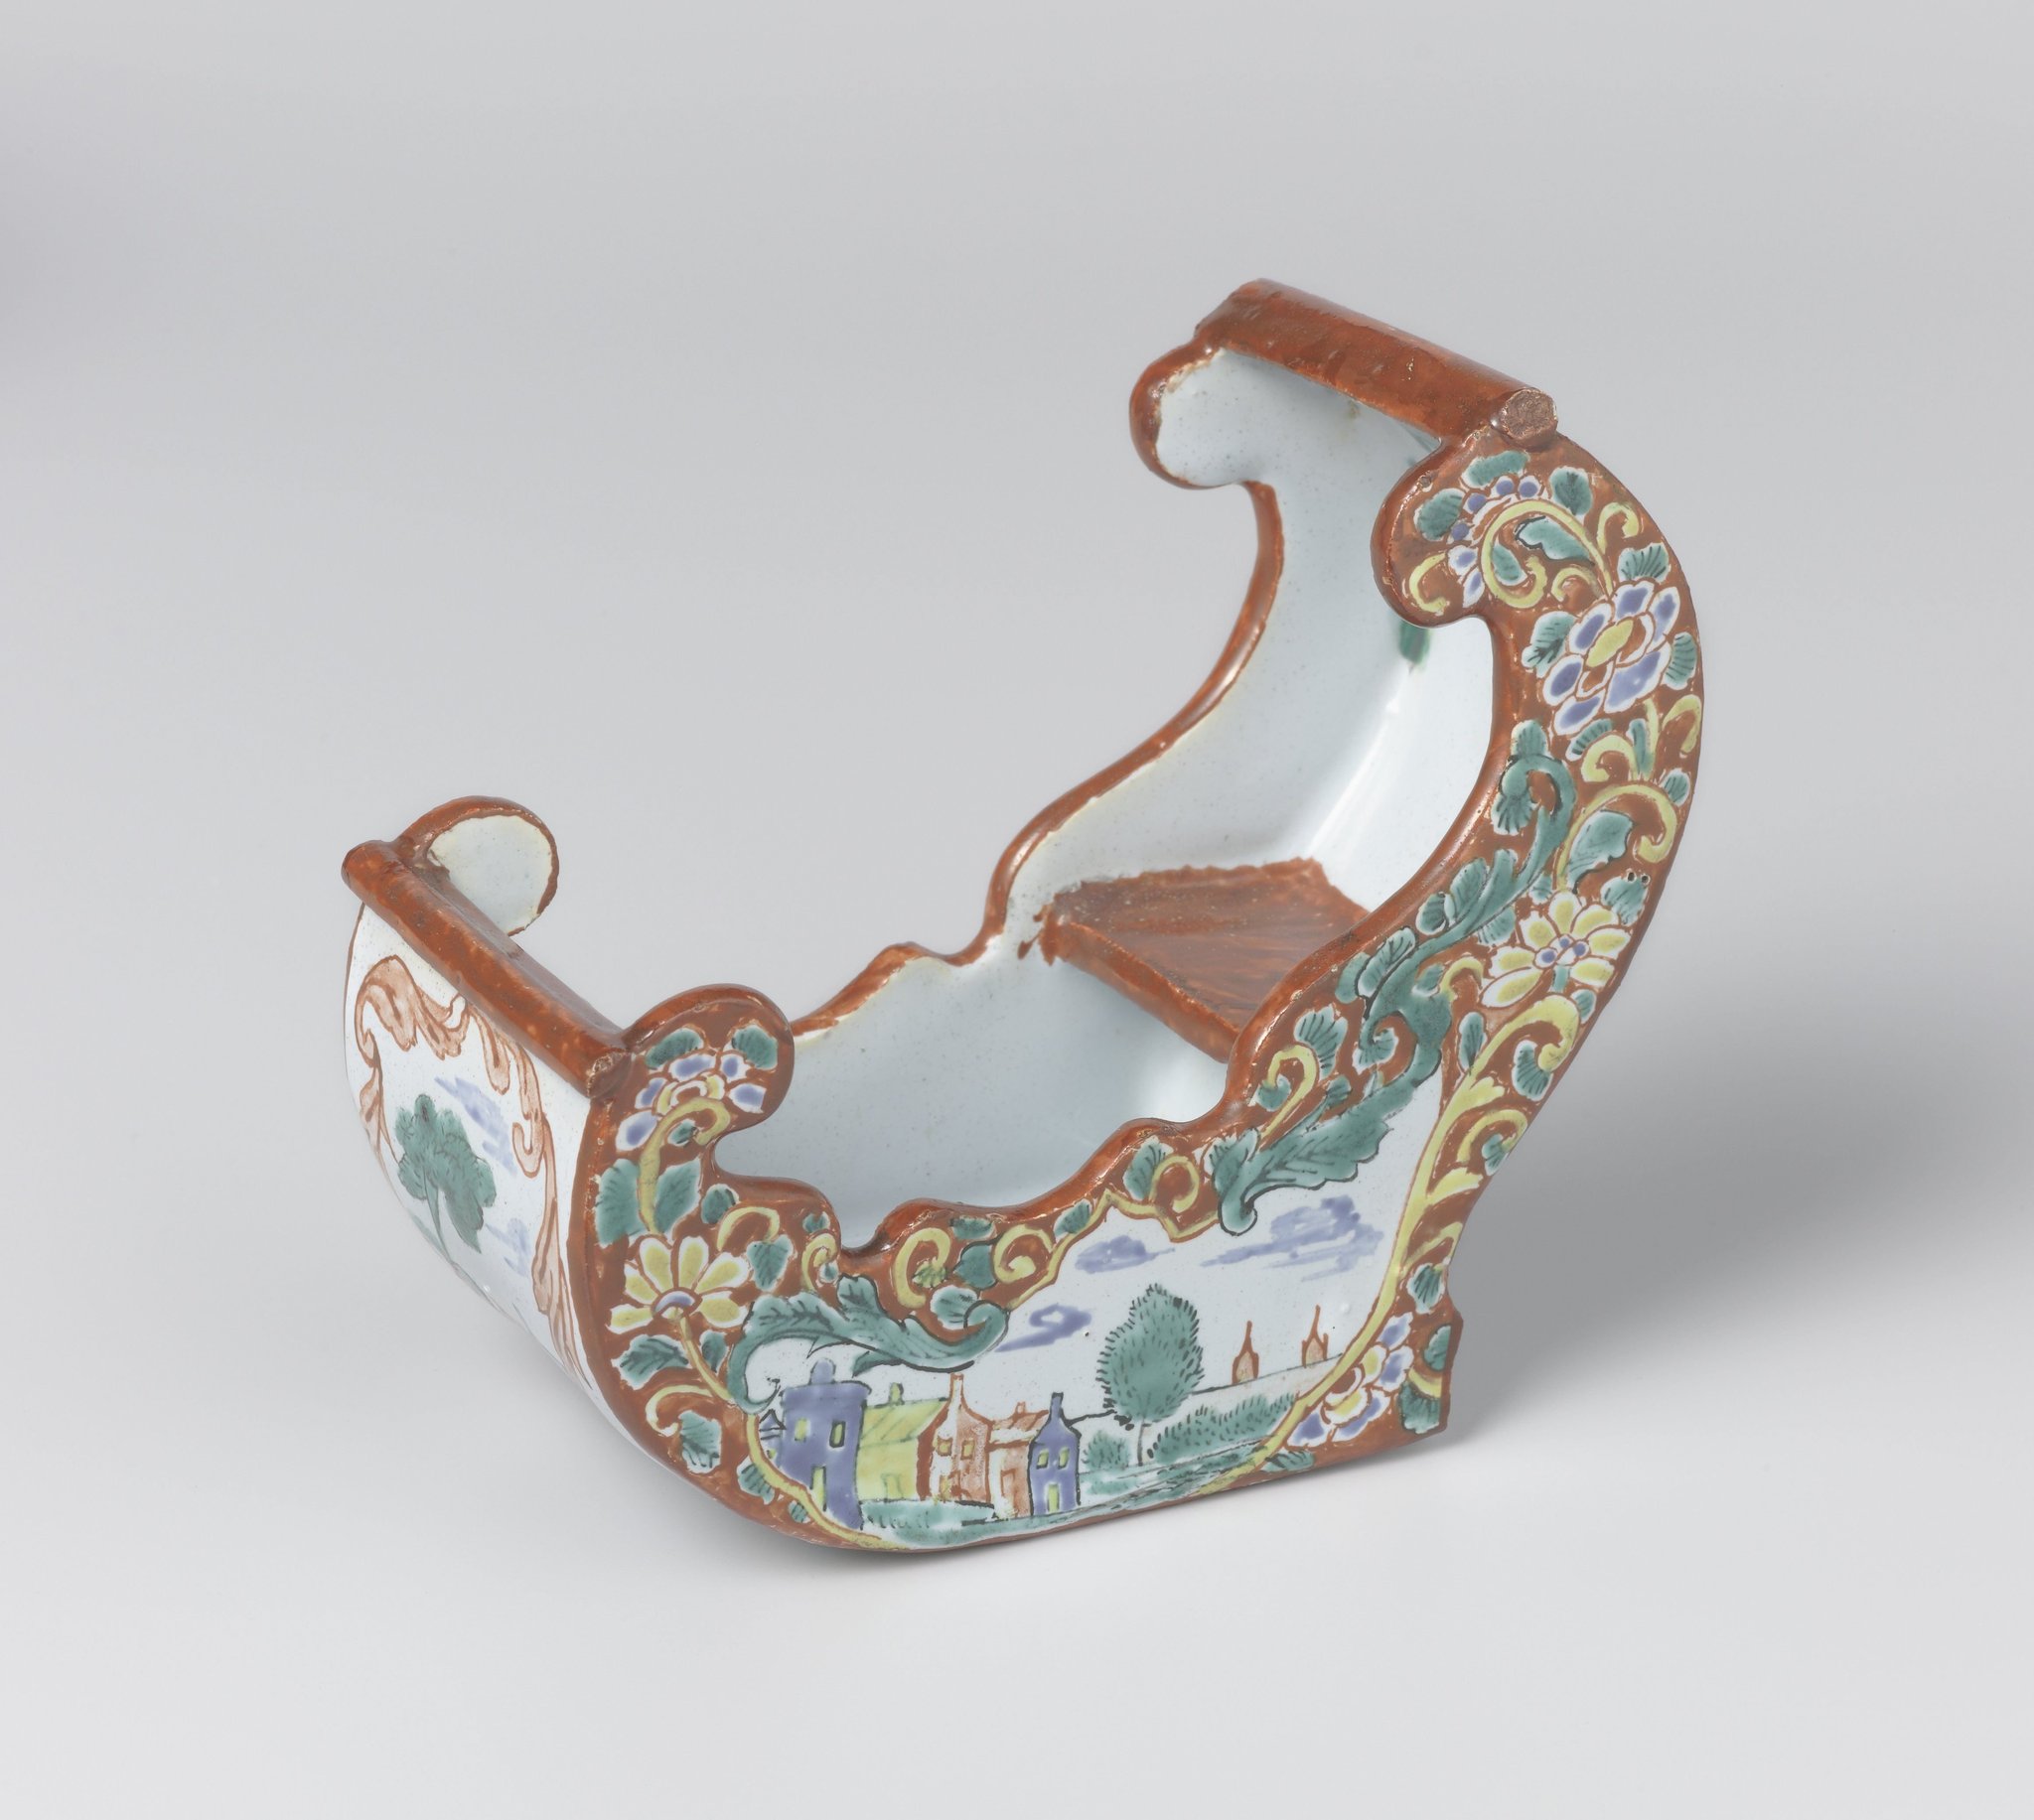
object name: pijpenslee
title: Veelkleurig beschilderde pijpenslee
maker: Anonymous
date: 1760-1800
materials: faience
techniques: kiln, painted, polychromy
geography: delft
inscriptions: collector's mark: ‘collection J.F. Loudon’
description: Pijpeslee met gebogen rug en geschulpte randen aan de zijkanten, veelkleurig beschilderd met waterlandschappen en een herder.